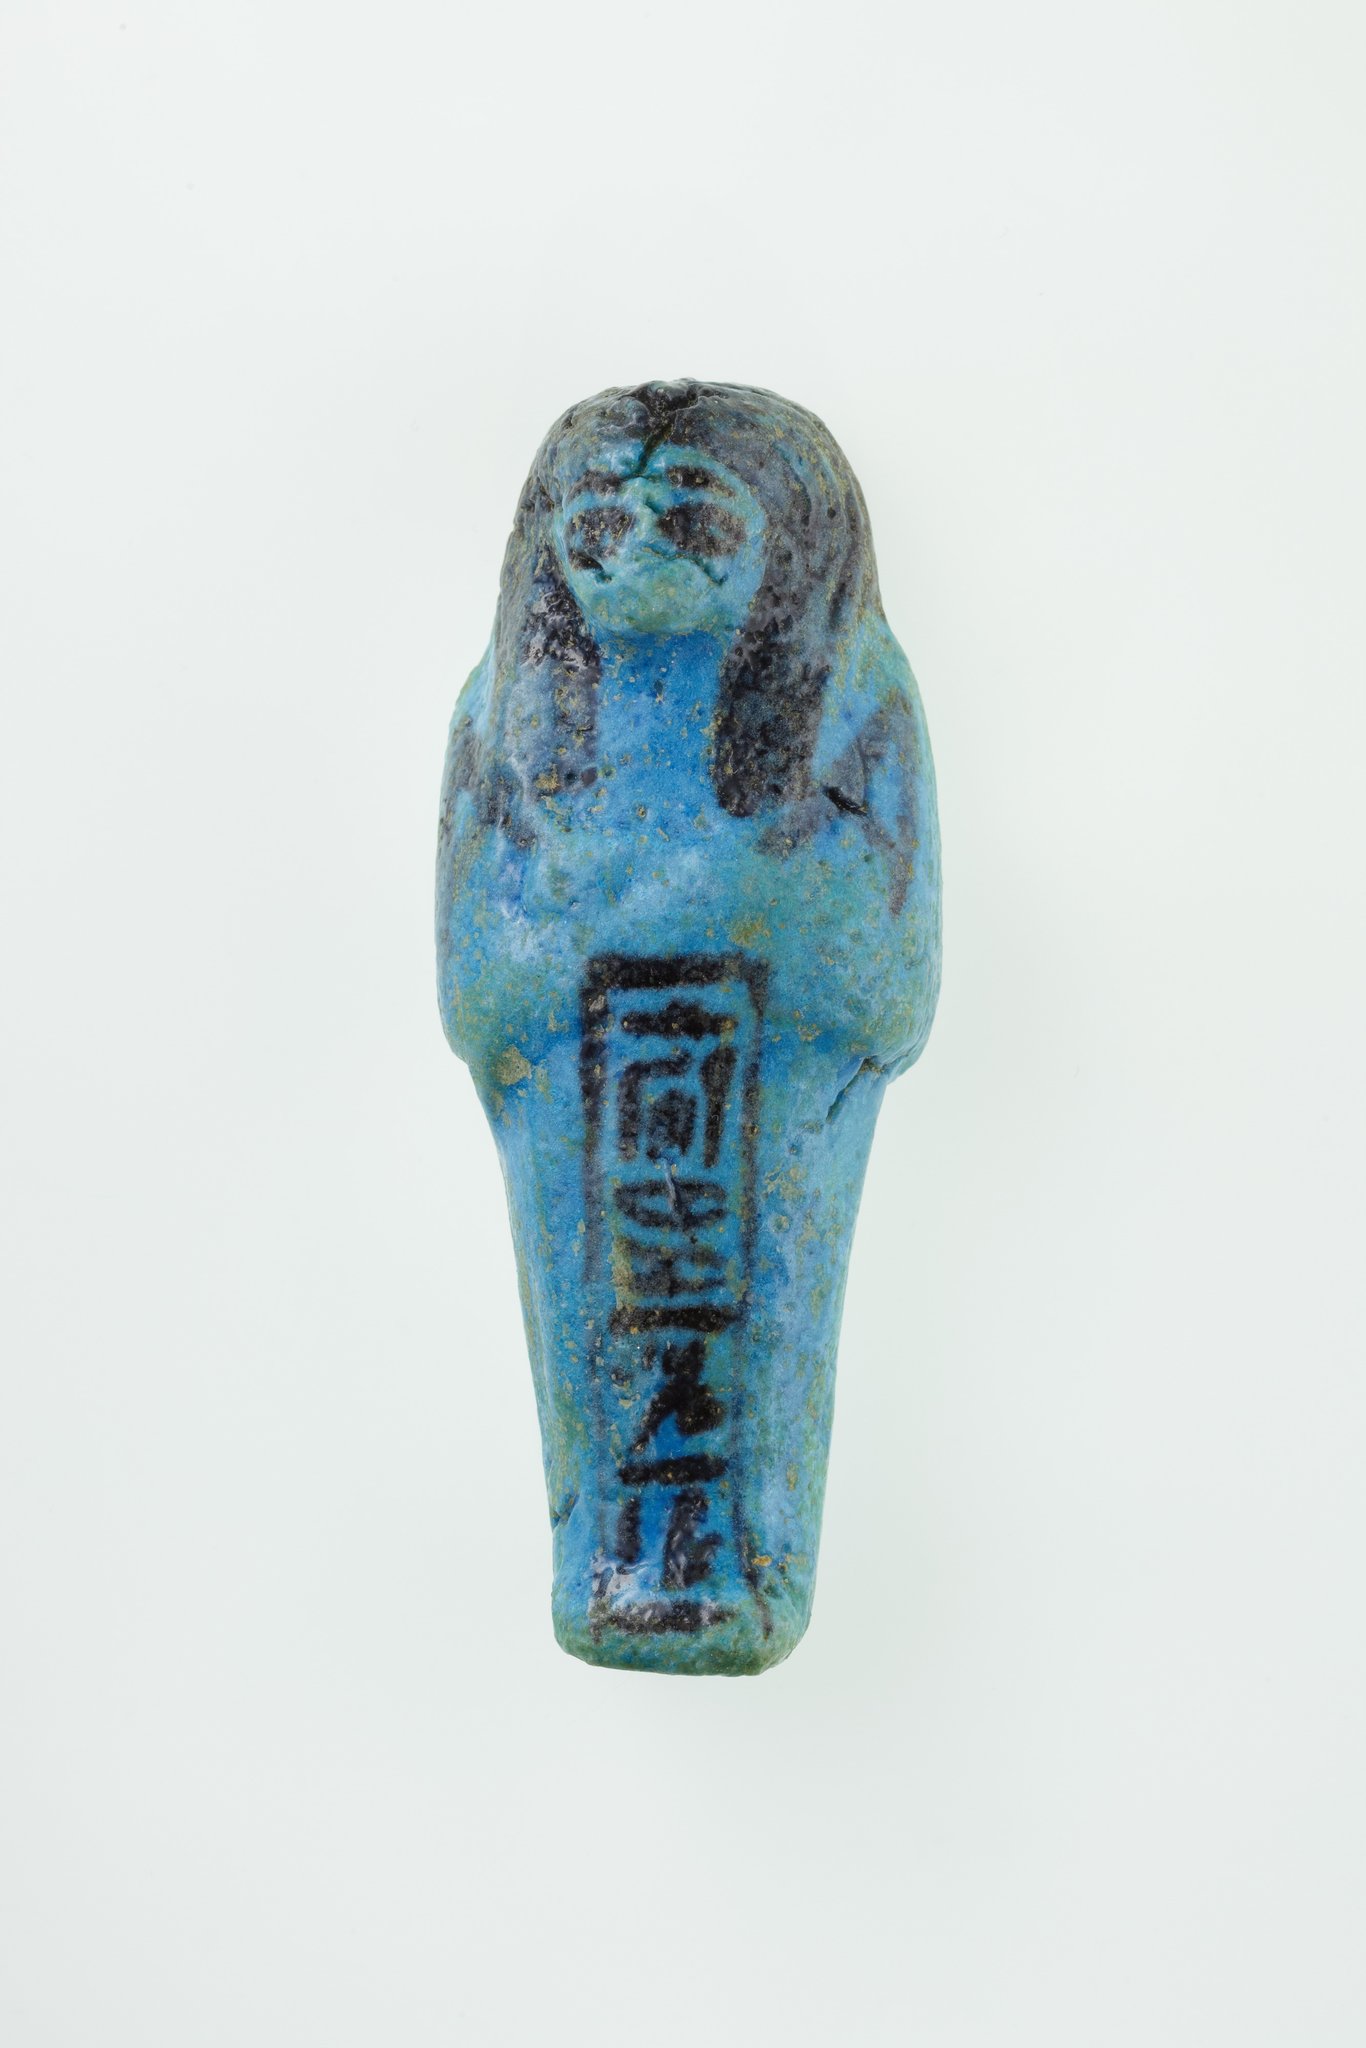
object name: shabti, worker, nauny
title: Worker Shabti of Nauny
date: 1050 BCE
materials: faience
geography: egypt